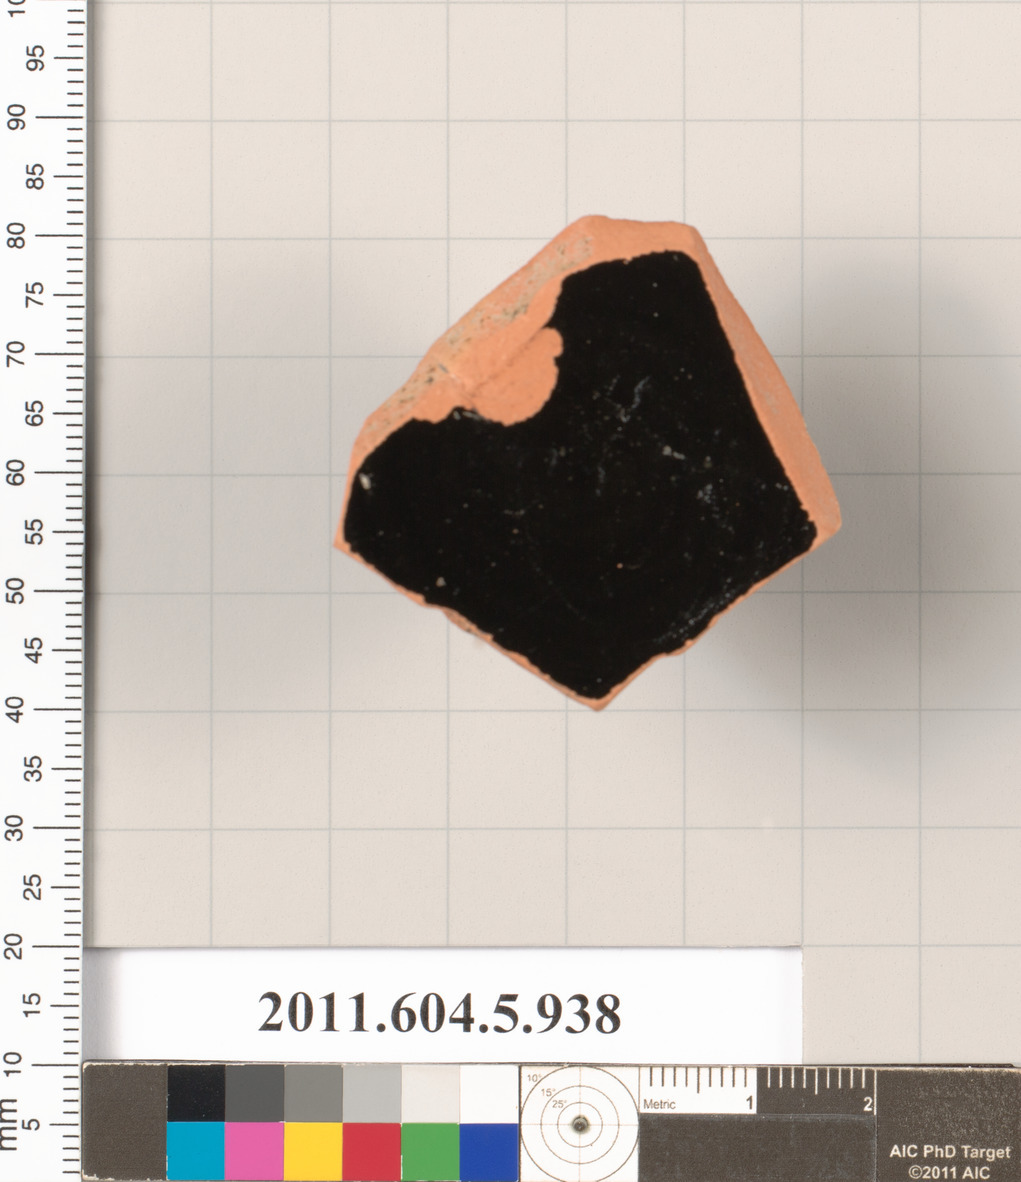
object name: kylix fragment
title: Terracotta fragment of a kylix (drinking cup)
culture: greek, attic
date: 600-401 BCE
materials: terracotta